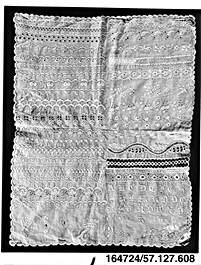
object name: sampler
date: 1858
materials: cotton